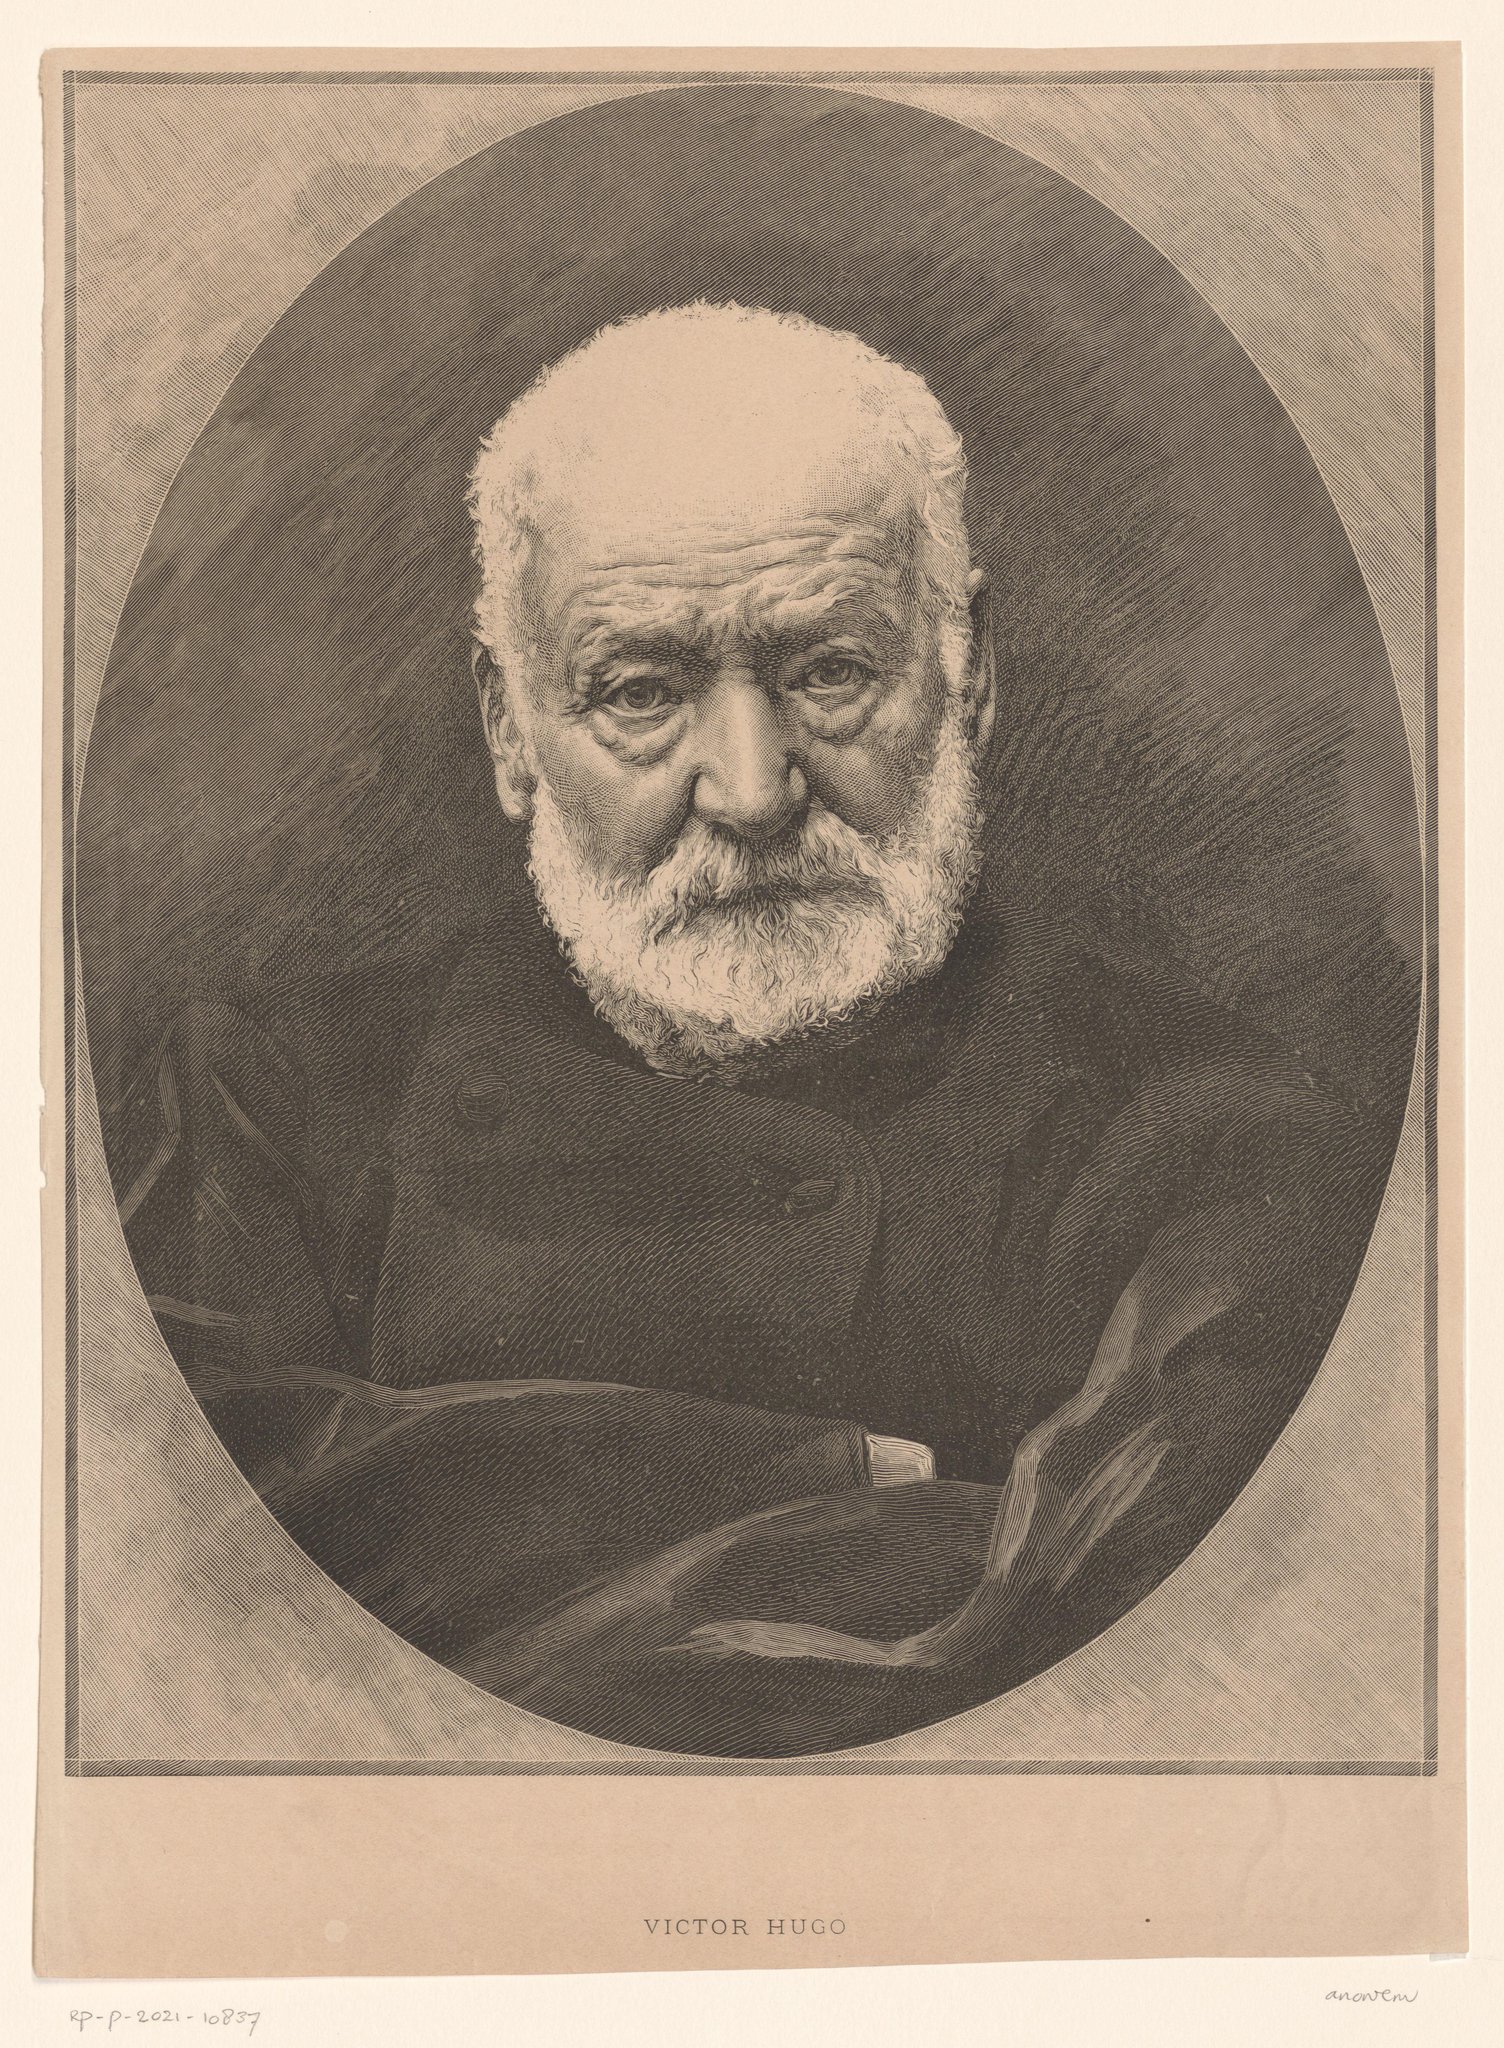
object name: print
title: Portret van Victor Hugo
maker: Anonymous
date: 1860-1899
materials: paper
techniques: engraving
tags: paris, victor hugo, historical persons, portrait of a writer